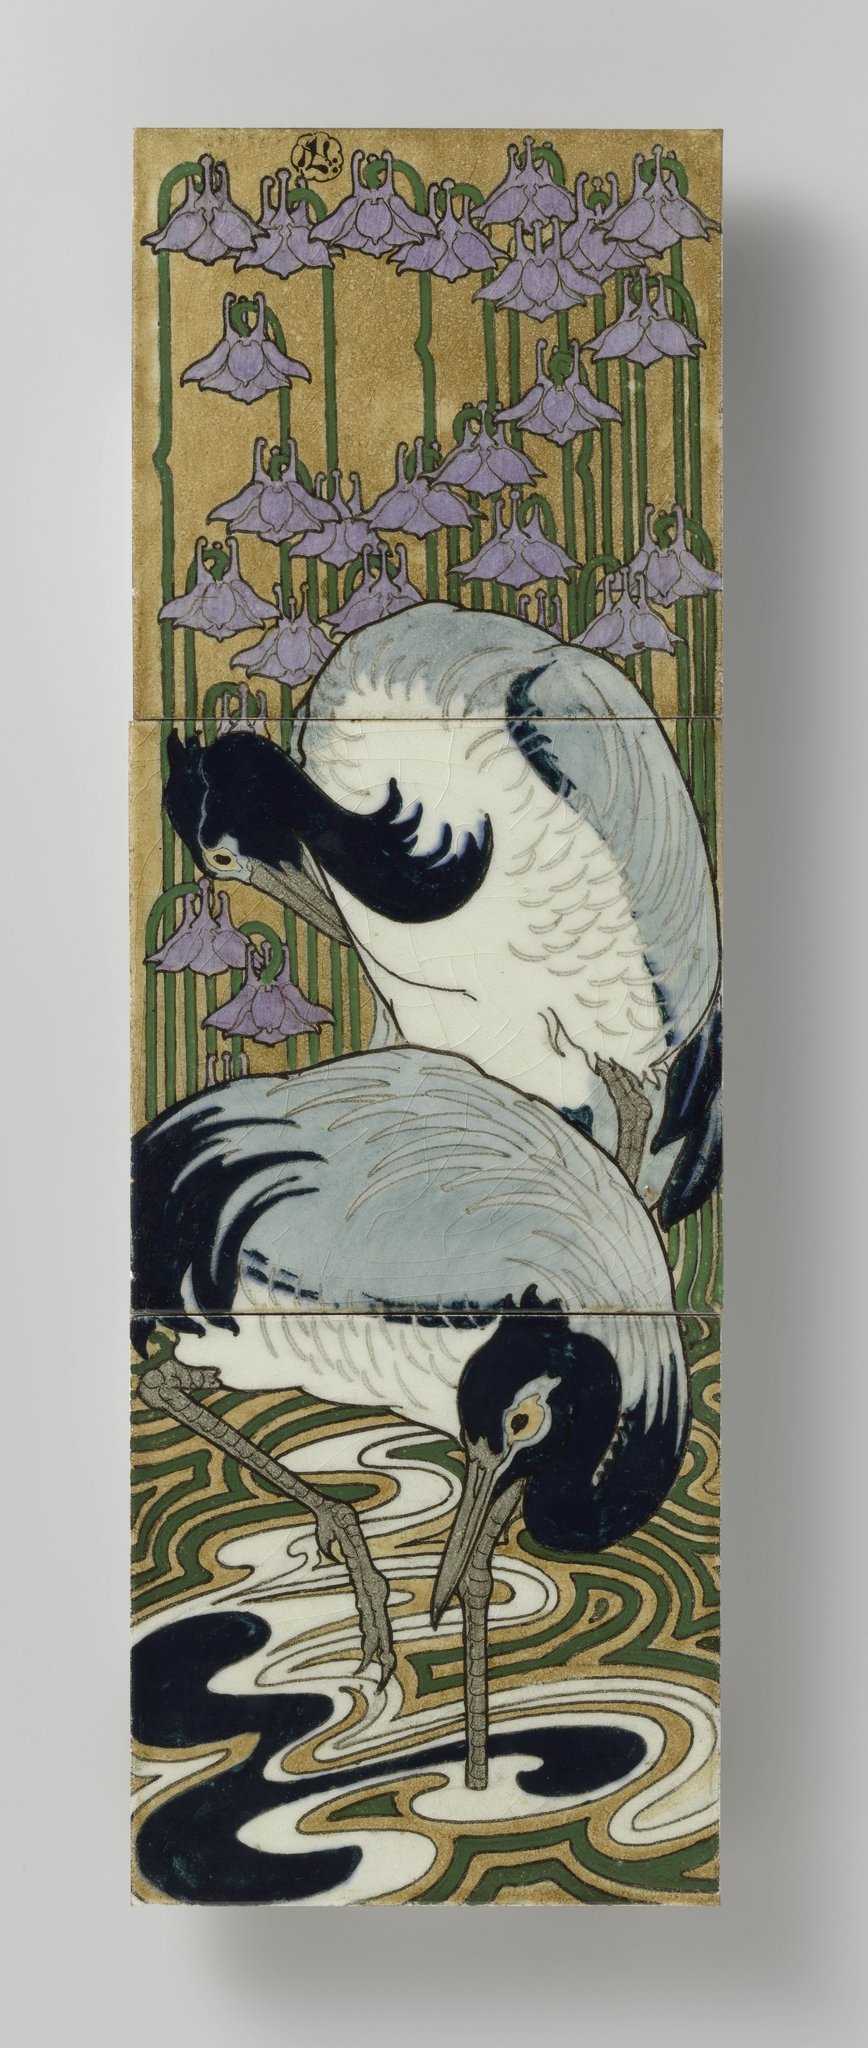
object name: tile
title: Tegeltableau, beschilderd met kraanvogels en akeleien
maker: bert nienhuis (i)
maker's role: designer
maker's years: 1873-1960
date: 1896-1901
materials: earthenware, wood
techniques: painted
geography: amsterdam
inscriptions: mark: ‘Boch Frères, La Louvière, A.’, monogram: ‘LN’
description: Tegeltableau in houten lijst, beschilderd met kraanvogels en akeleien in de kleuren groen, paars, licht- en donkerblauw, grijsbruin, wit en zwart op bruingele fond.